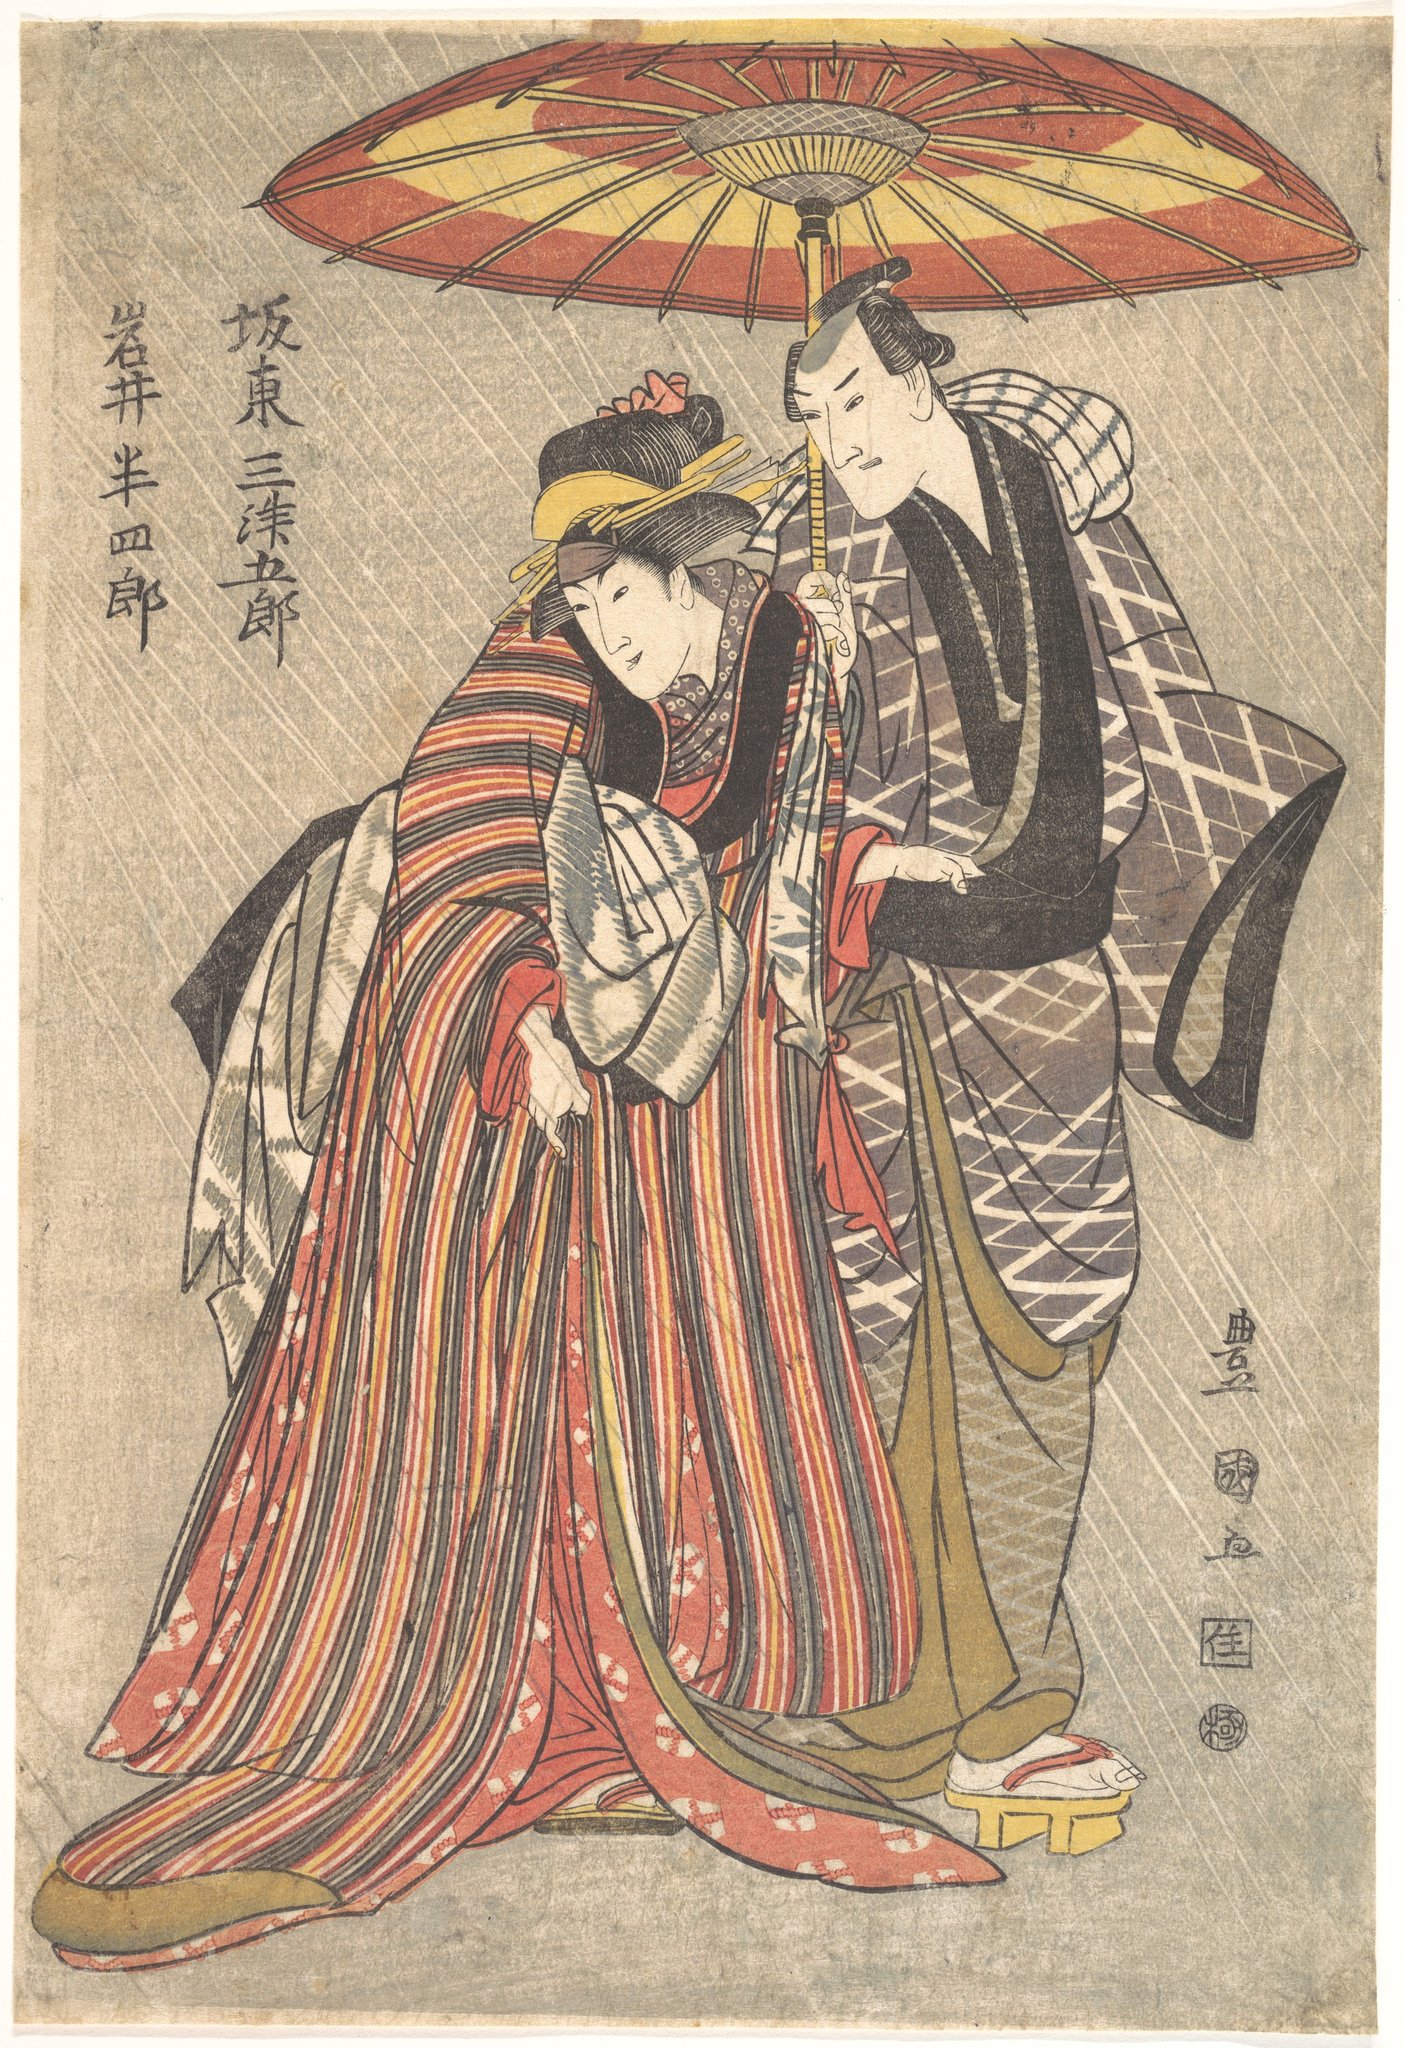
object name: print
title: Kabuki Actors: Bando Mitsugorō and Iwai Hanshirō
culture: japanese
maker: utagawa toyokuni i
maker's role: artist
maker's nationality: japanese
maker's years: 1769-1825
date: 1800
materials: ink, paper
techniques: woodblock print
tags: men,women,actors